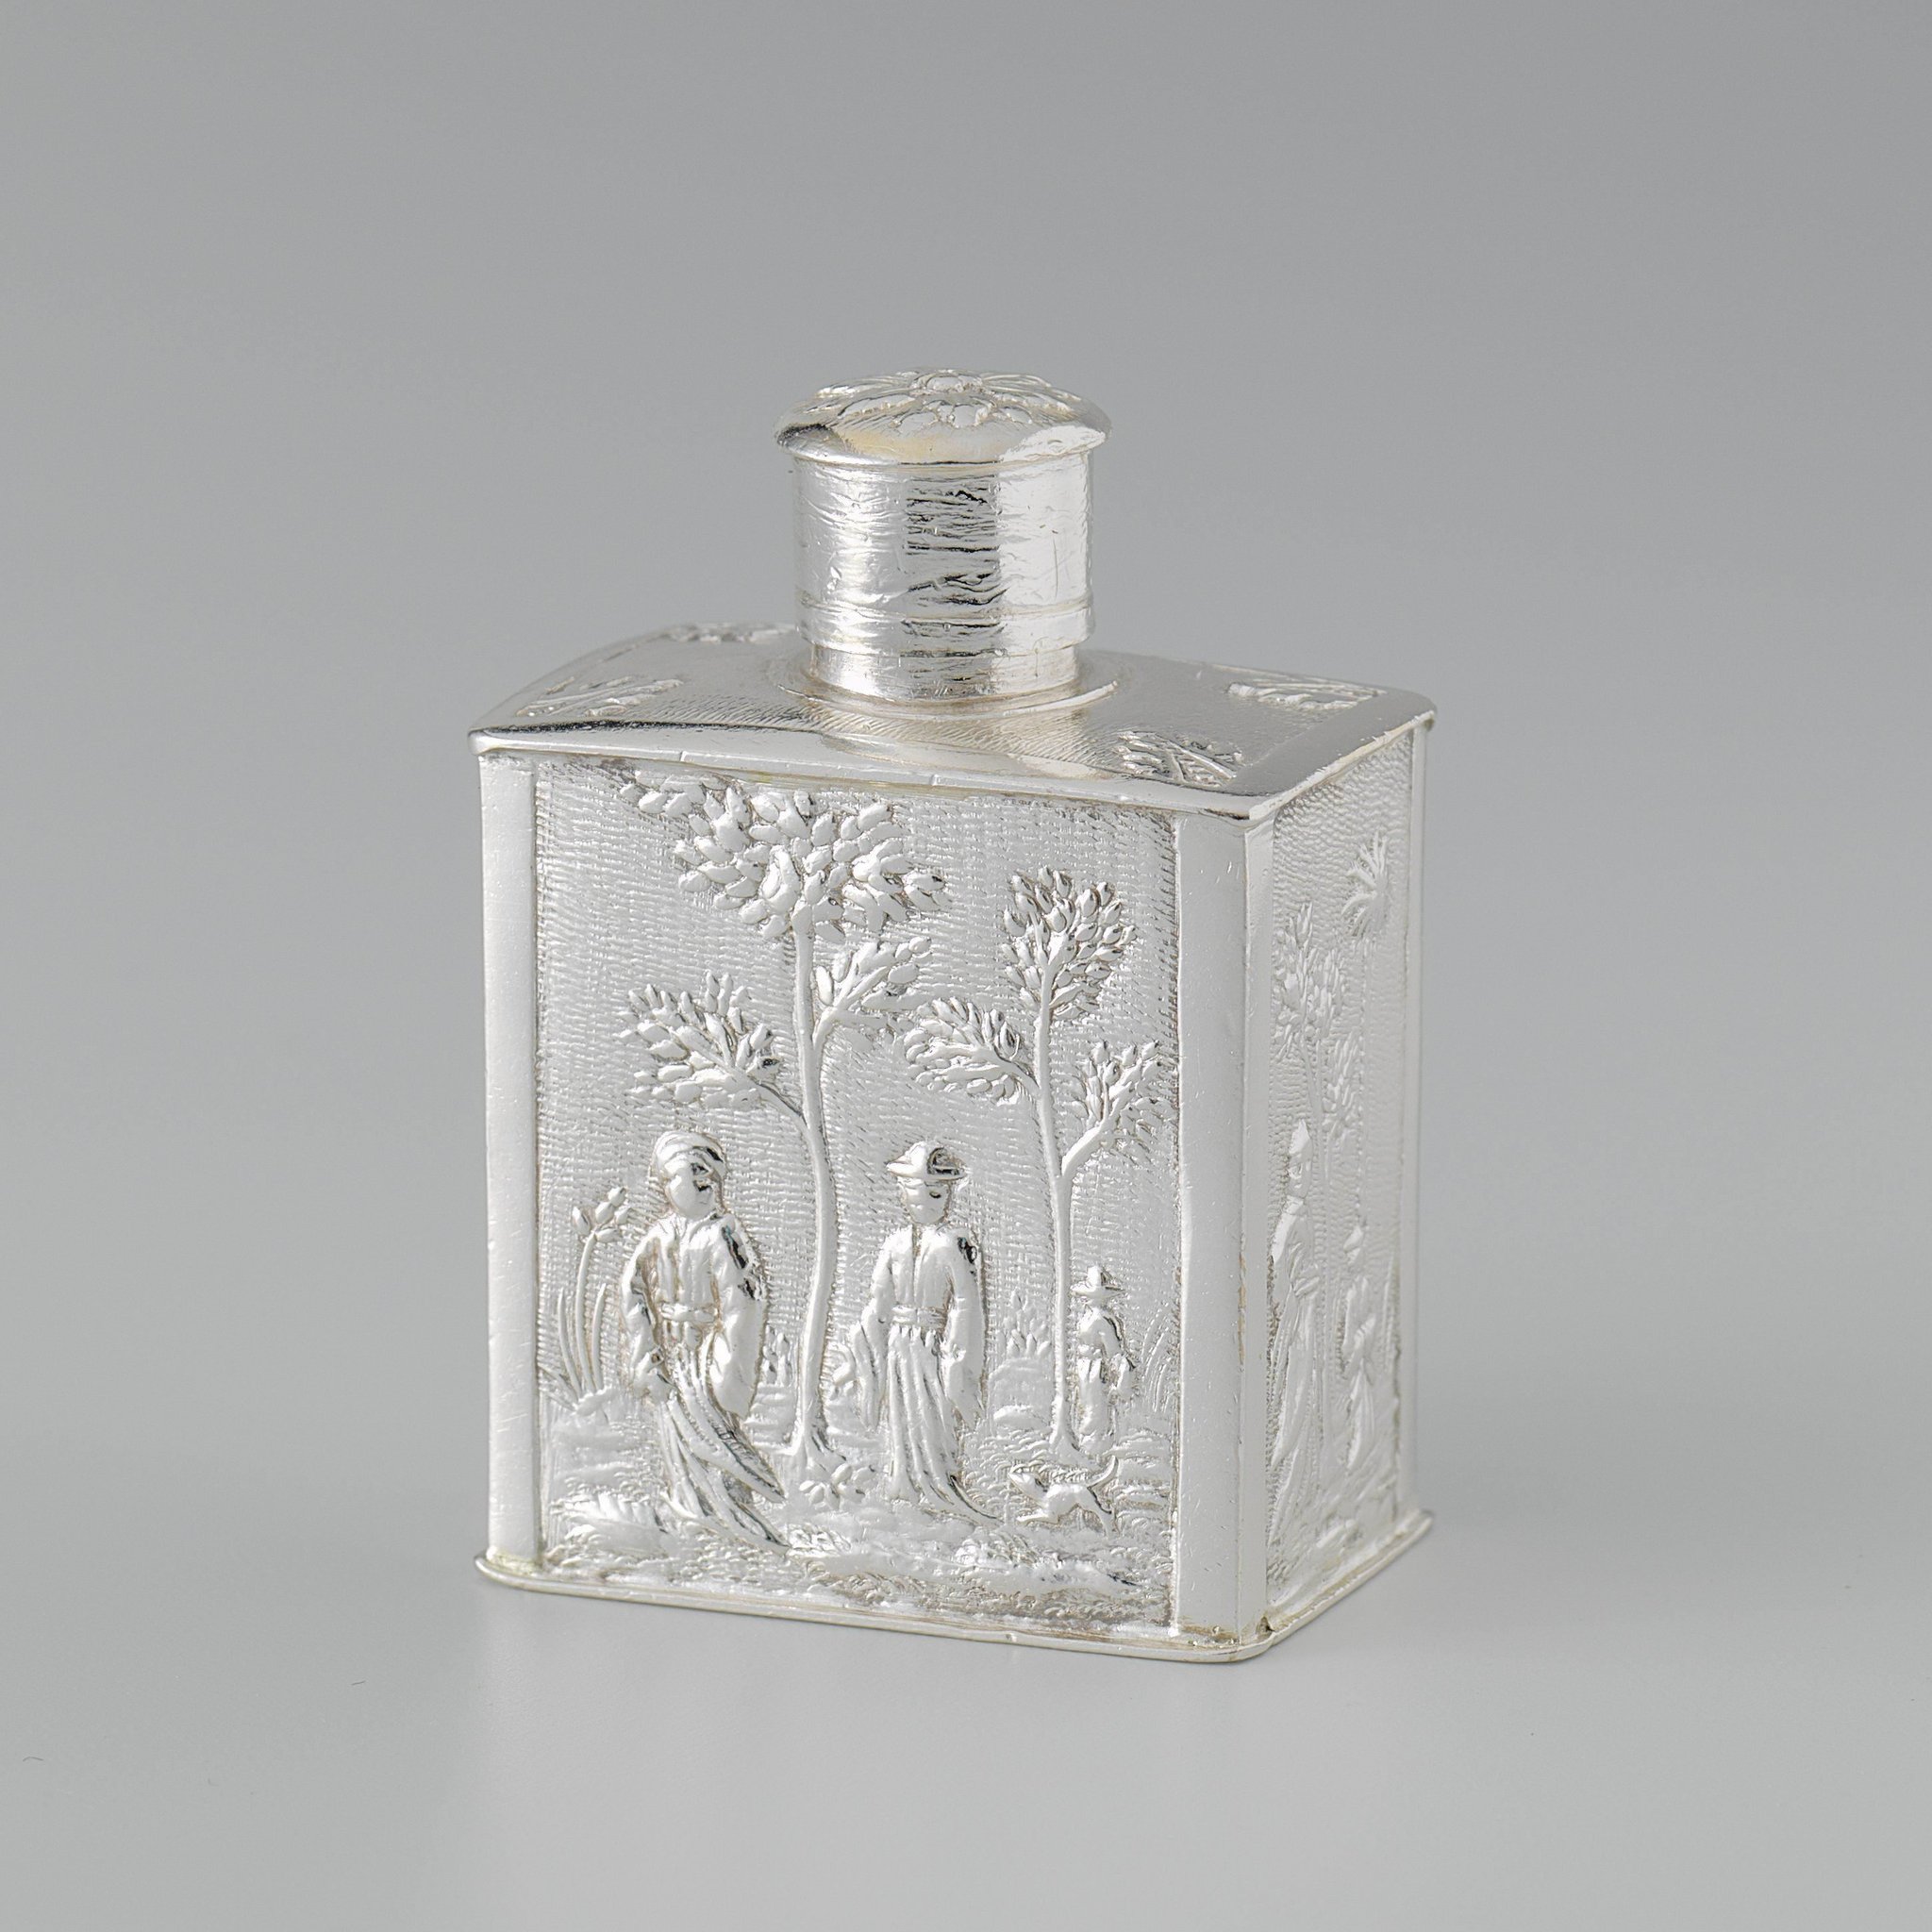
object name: miniature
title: Theebus met chinoiserieën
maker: cornelis coutrier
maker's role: silversmith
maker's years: 1702-1749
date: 1730-1749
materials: silver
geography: amsterdam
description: Rechthoekige theebus met een verhoogde, ronde deksel. Op elke wand is een landschap met chinezen afgebeeld. De hoeken van de bovenzijde zijn versierd met bladmotieven. Op de bovenzijde van het deksel is een rozet. De theebus is gemerkt: stk.= Amsterdam, mt.= Cornelis Coutrier en een bijltje.